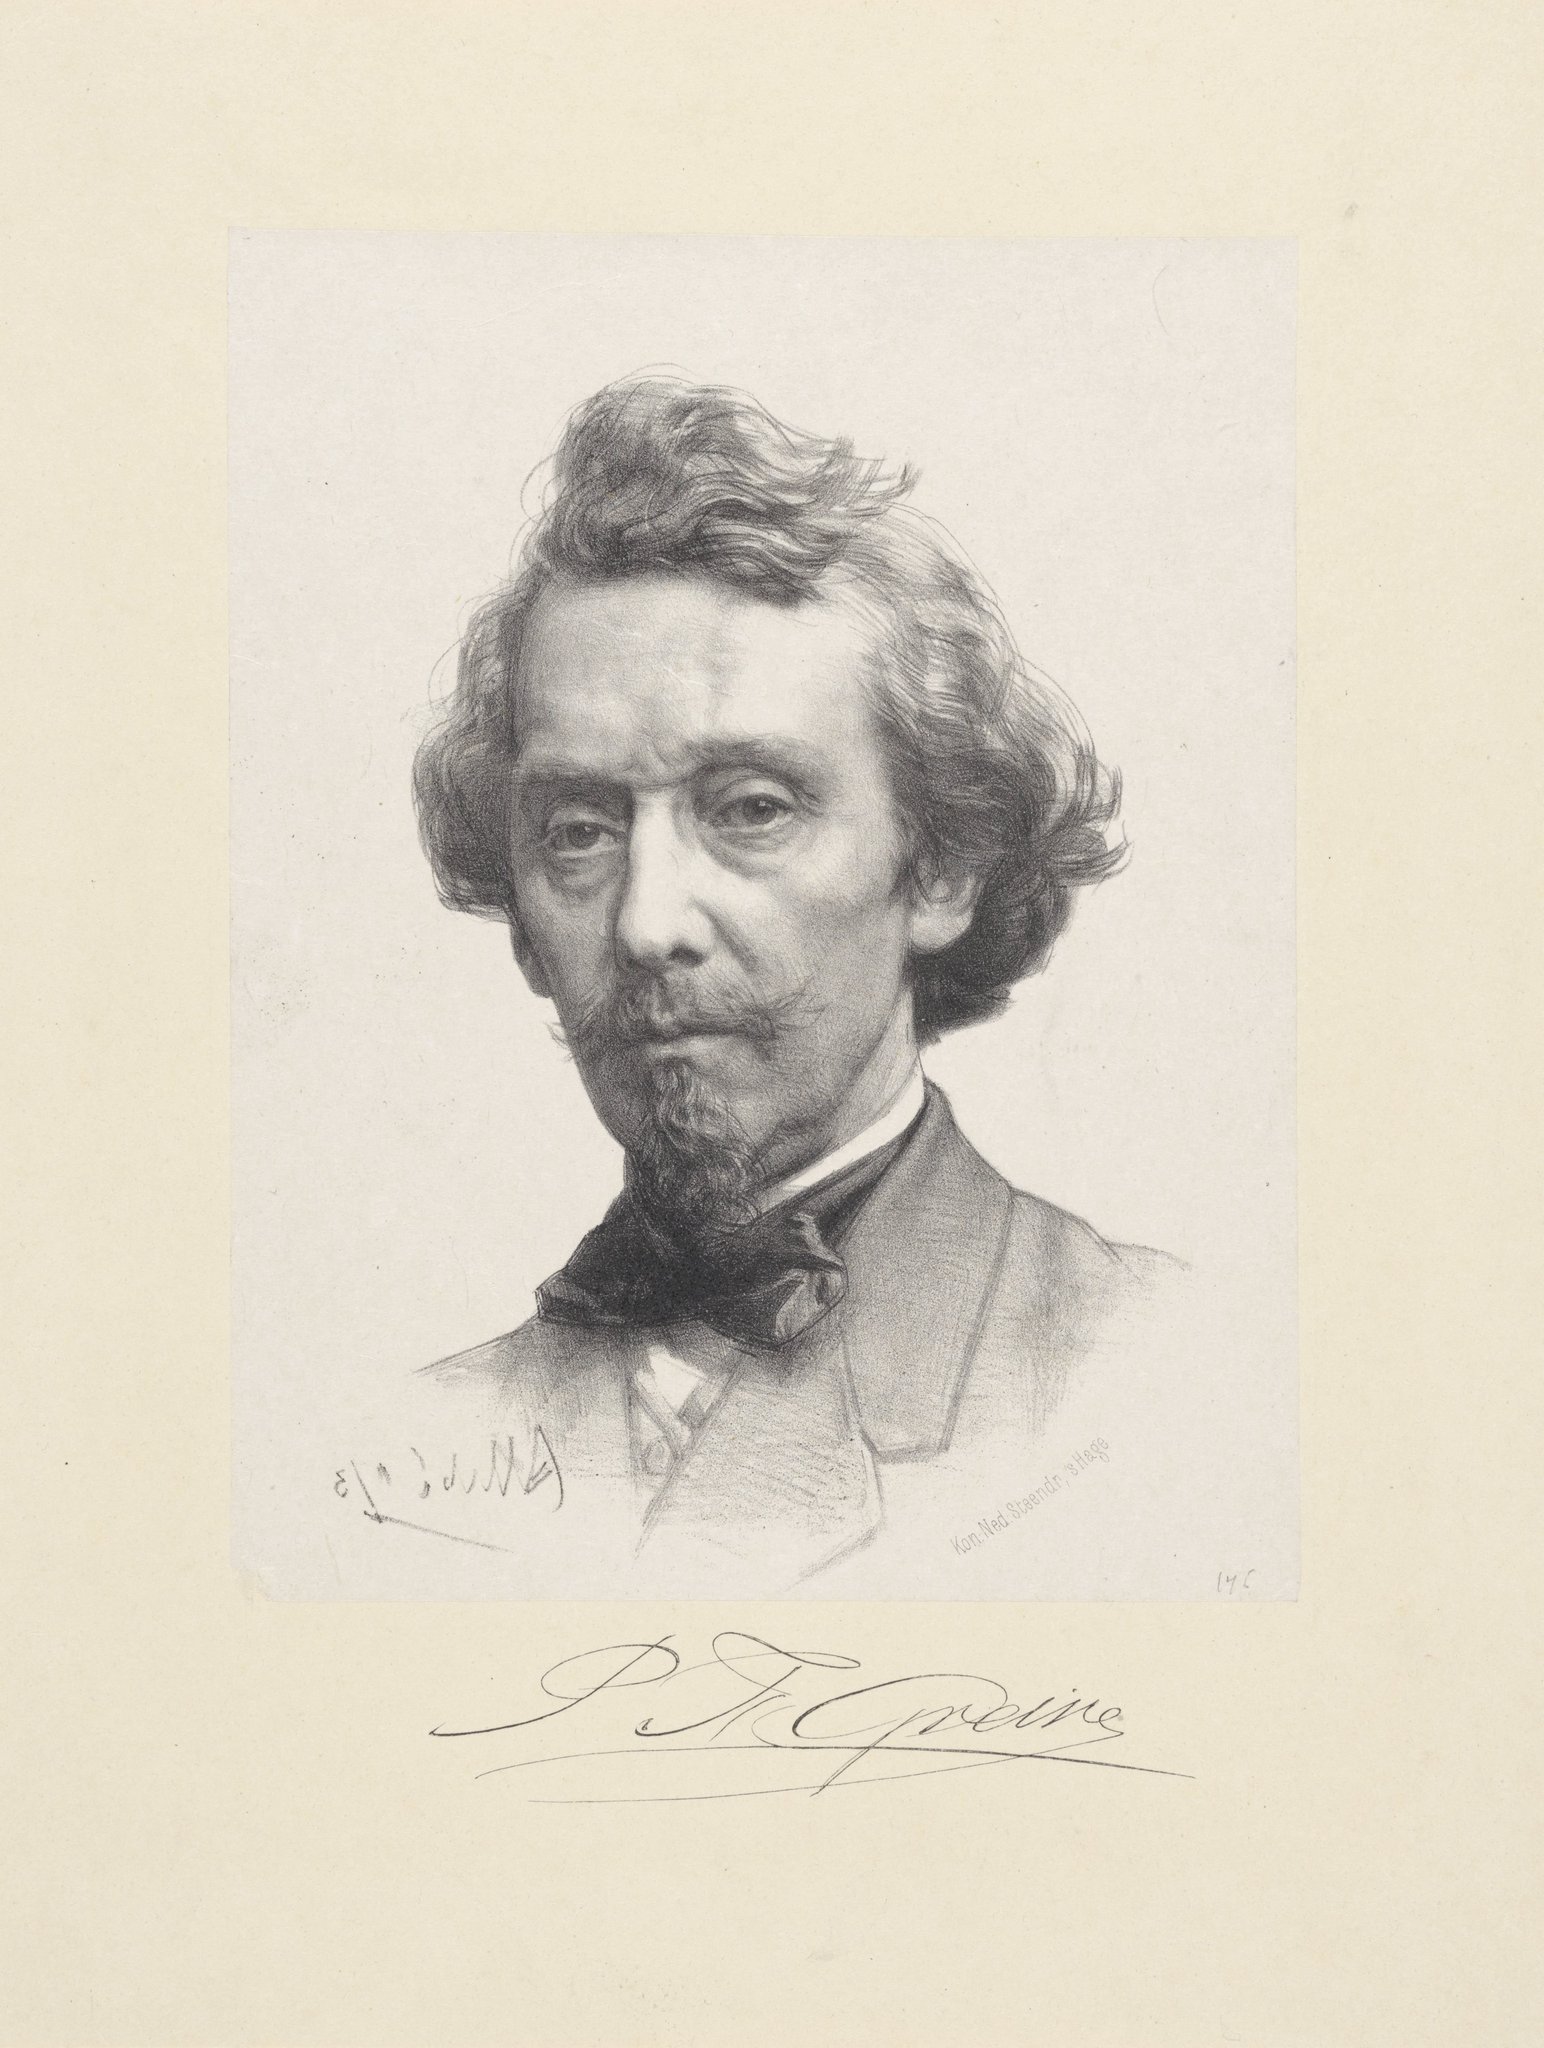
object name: print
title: Portret van kunstenaar Petrus Franciscus Greive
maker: august allebé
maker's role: draughtsman, print maker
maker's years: 1838-1927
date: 1873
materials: paper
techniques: lithography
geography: amsterdam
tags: amsterdam, print maker, draughtsman, petrus franciscus greive, portrait, self-portrait of artist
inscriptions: inscription: ‘146’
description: Onder het portret signatuur van de geportretteerde.